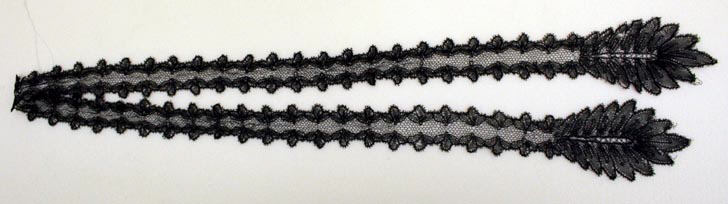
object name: necktie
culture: european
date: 1860-1865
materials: linen